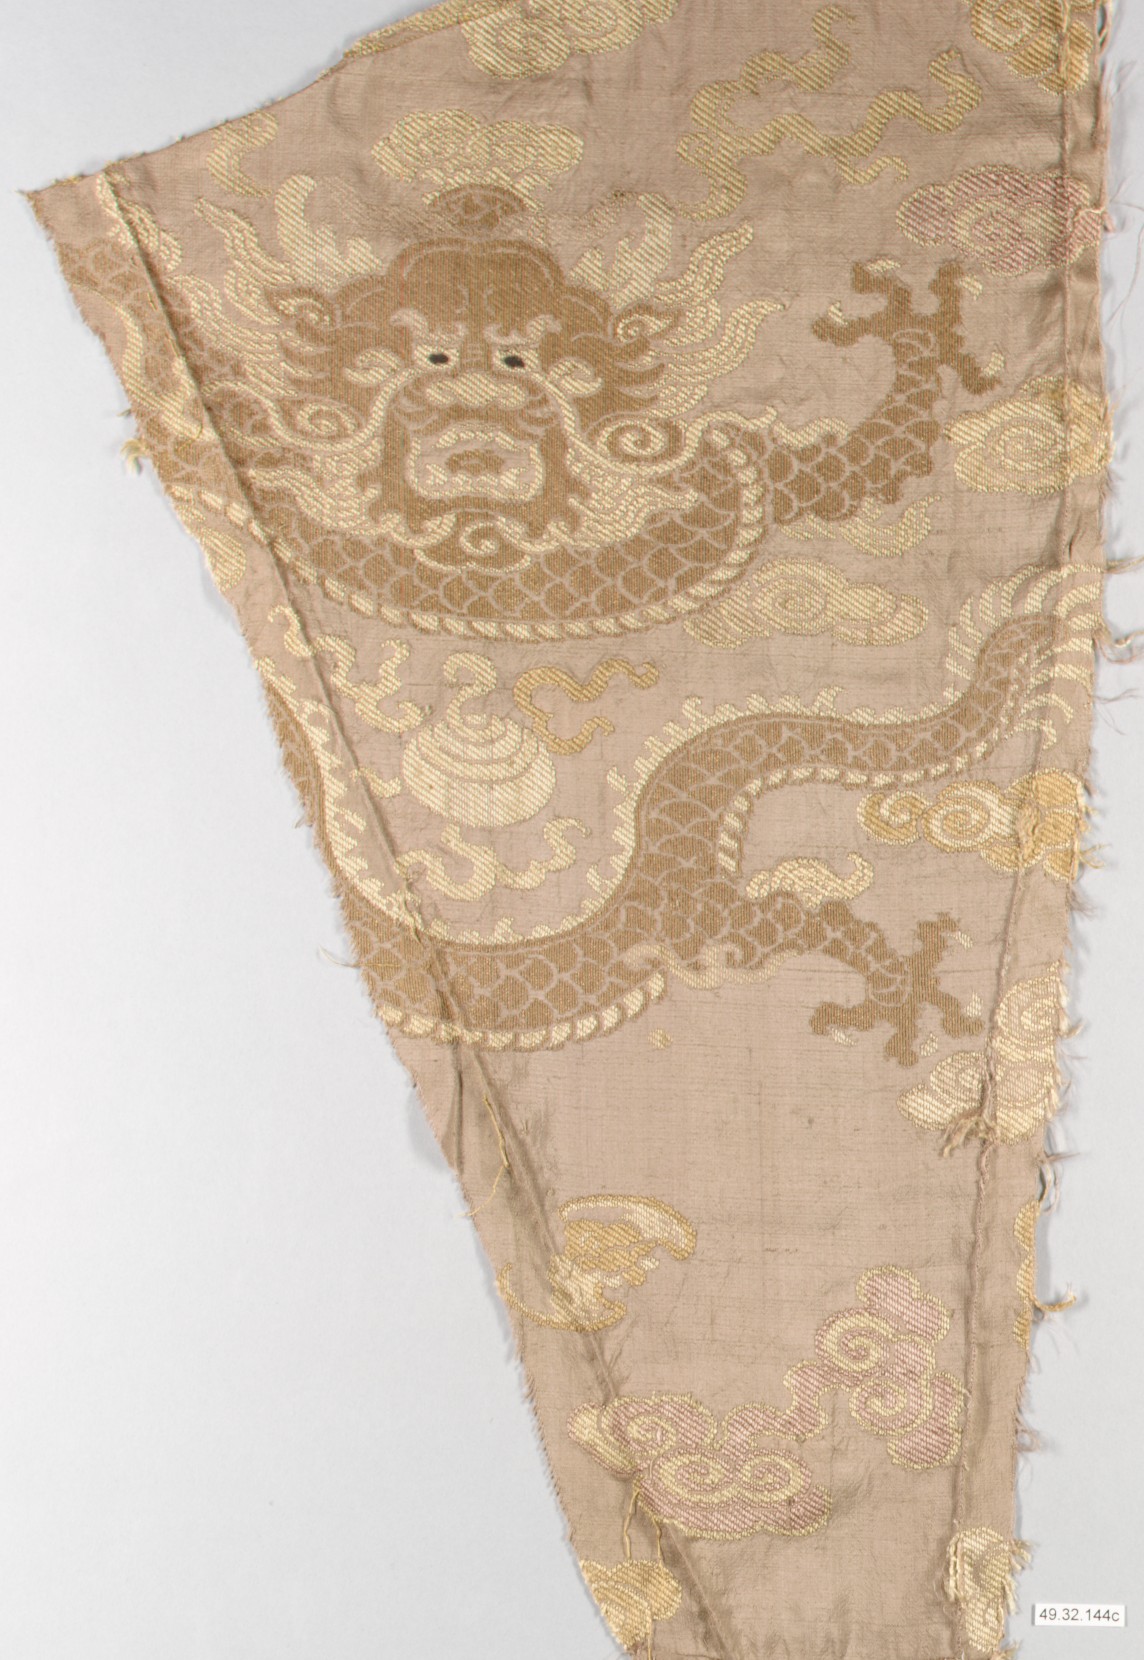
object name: fragment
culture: chinese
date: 1867-1900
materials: metal thread, silk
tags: dragons